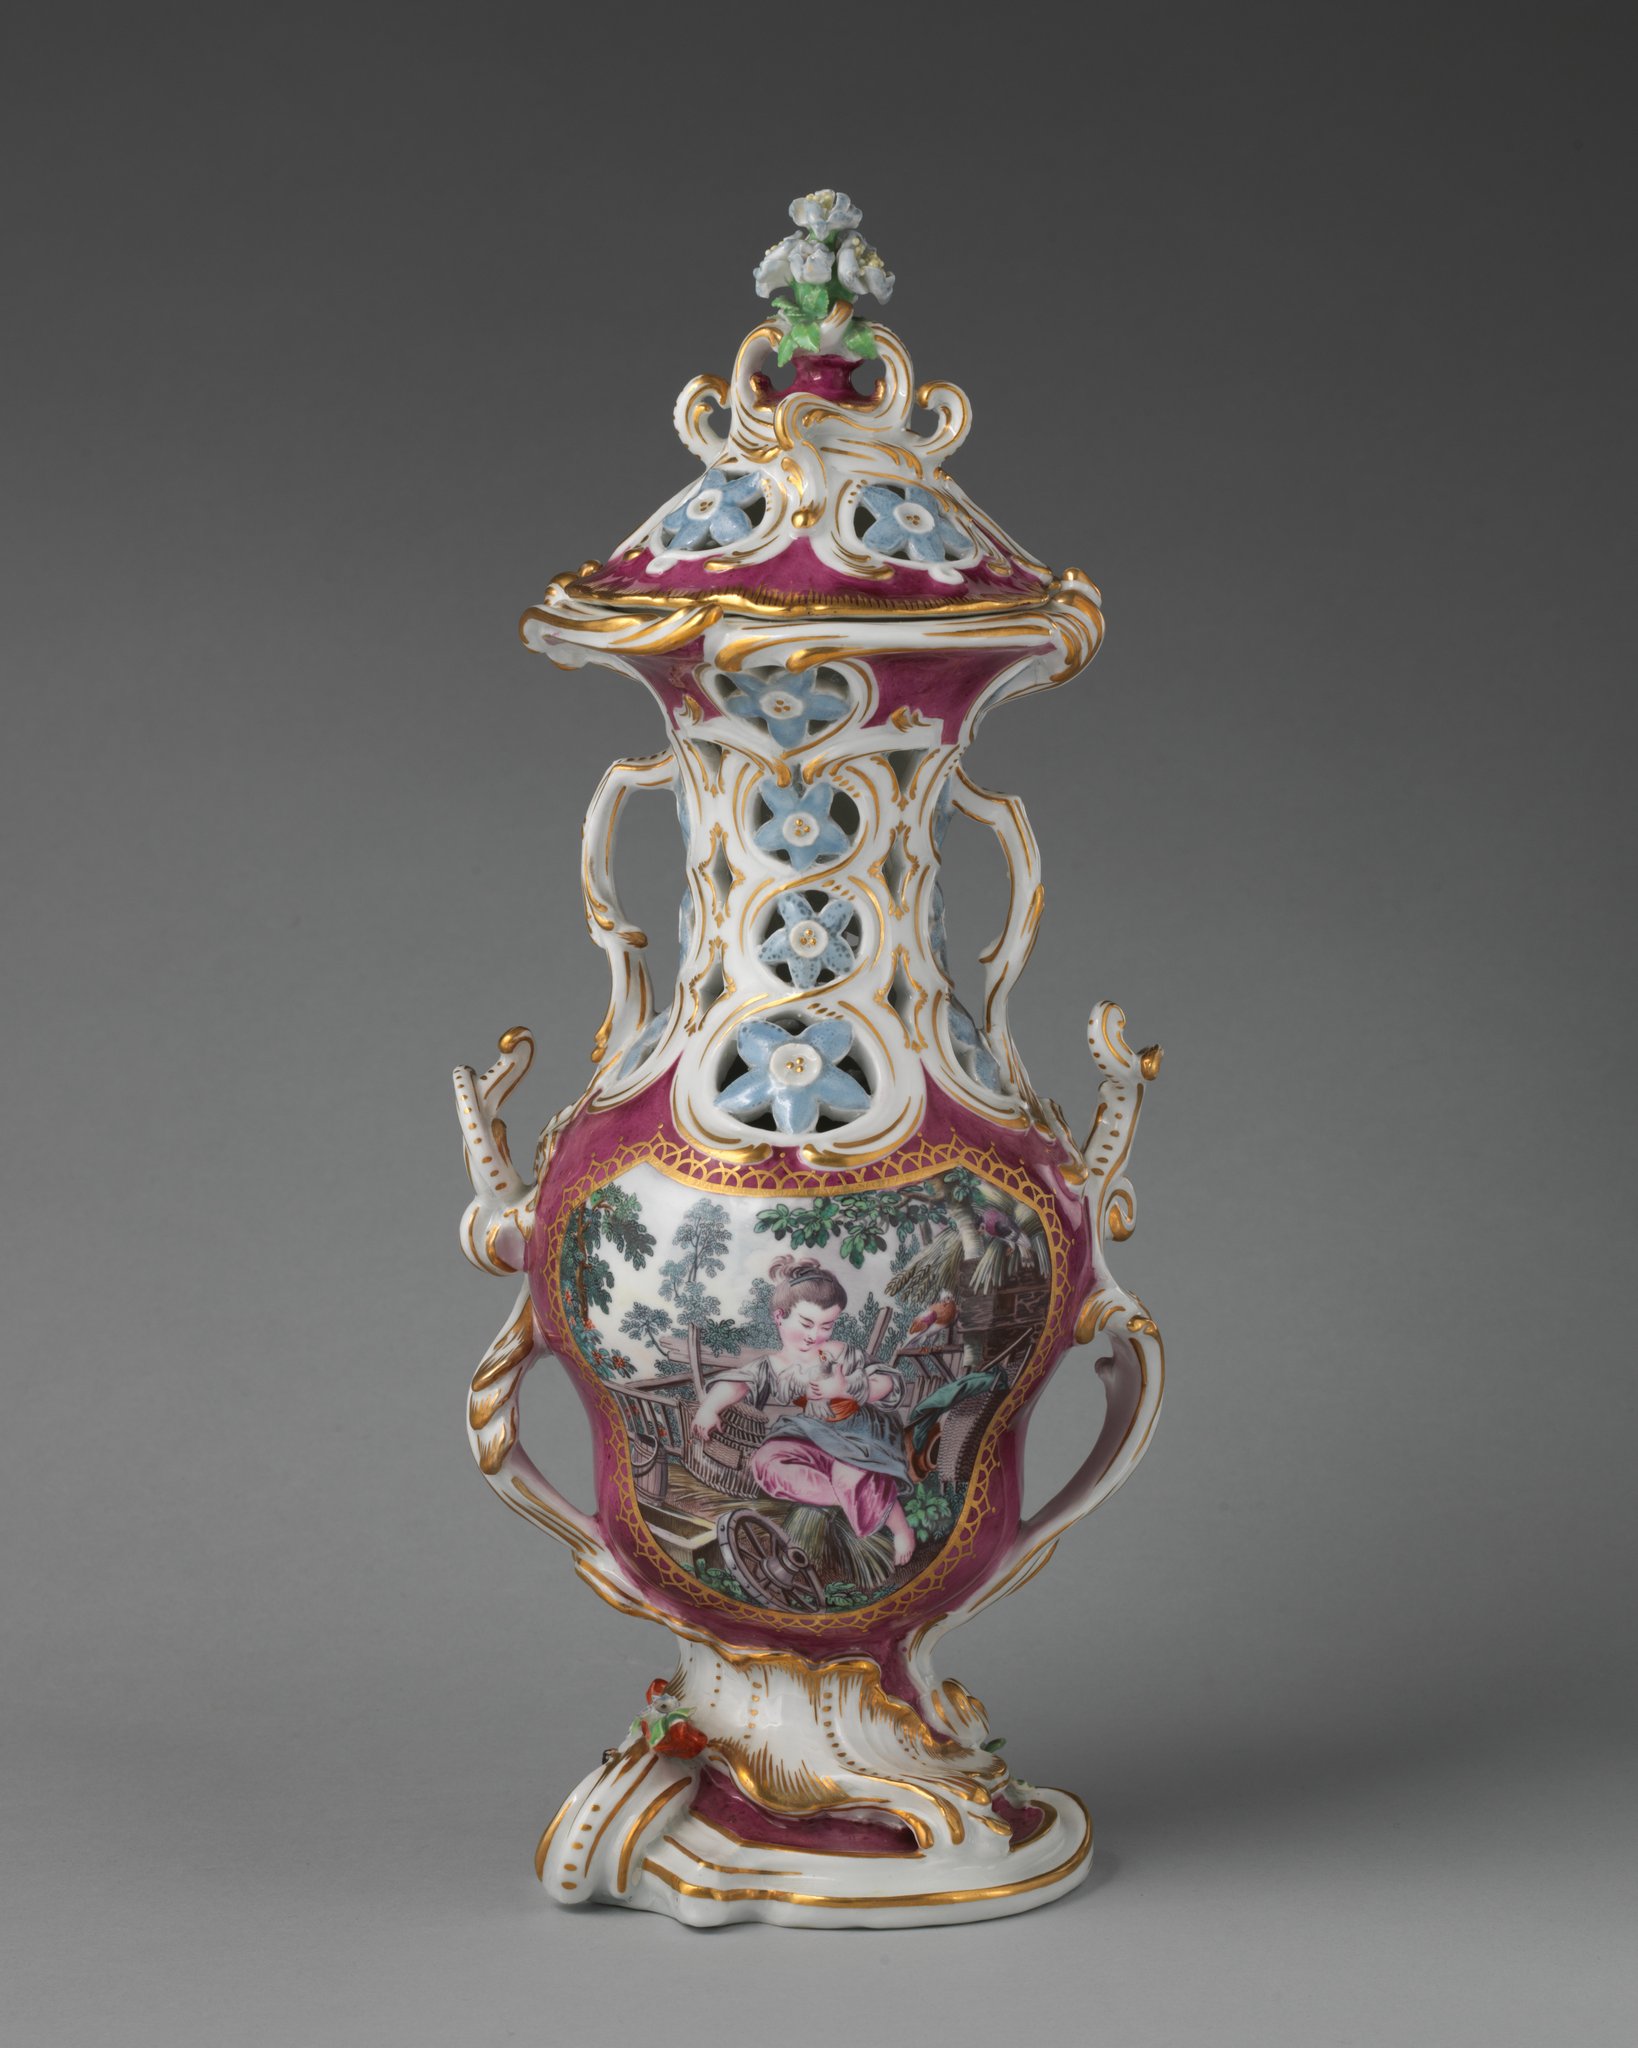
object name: vase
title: Vase (one of a set of three)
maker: chelsea porcelain manufactory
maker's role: factory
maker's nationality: british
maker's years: 1744-1784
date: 1761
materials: soft paste porcelain